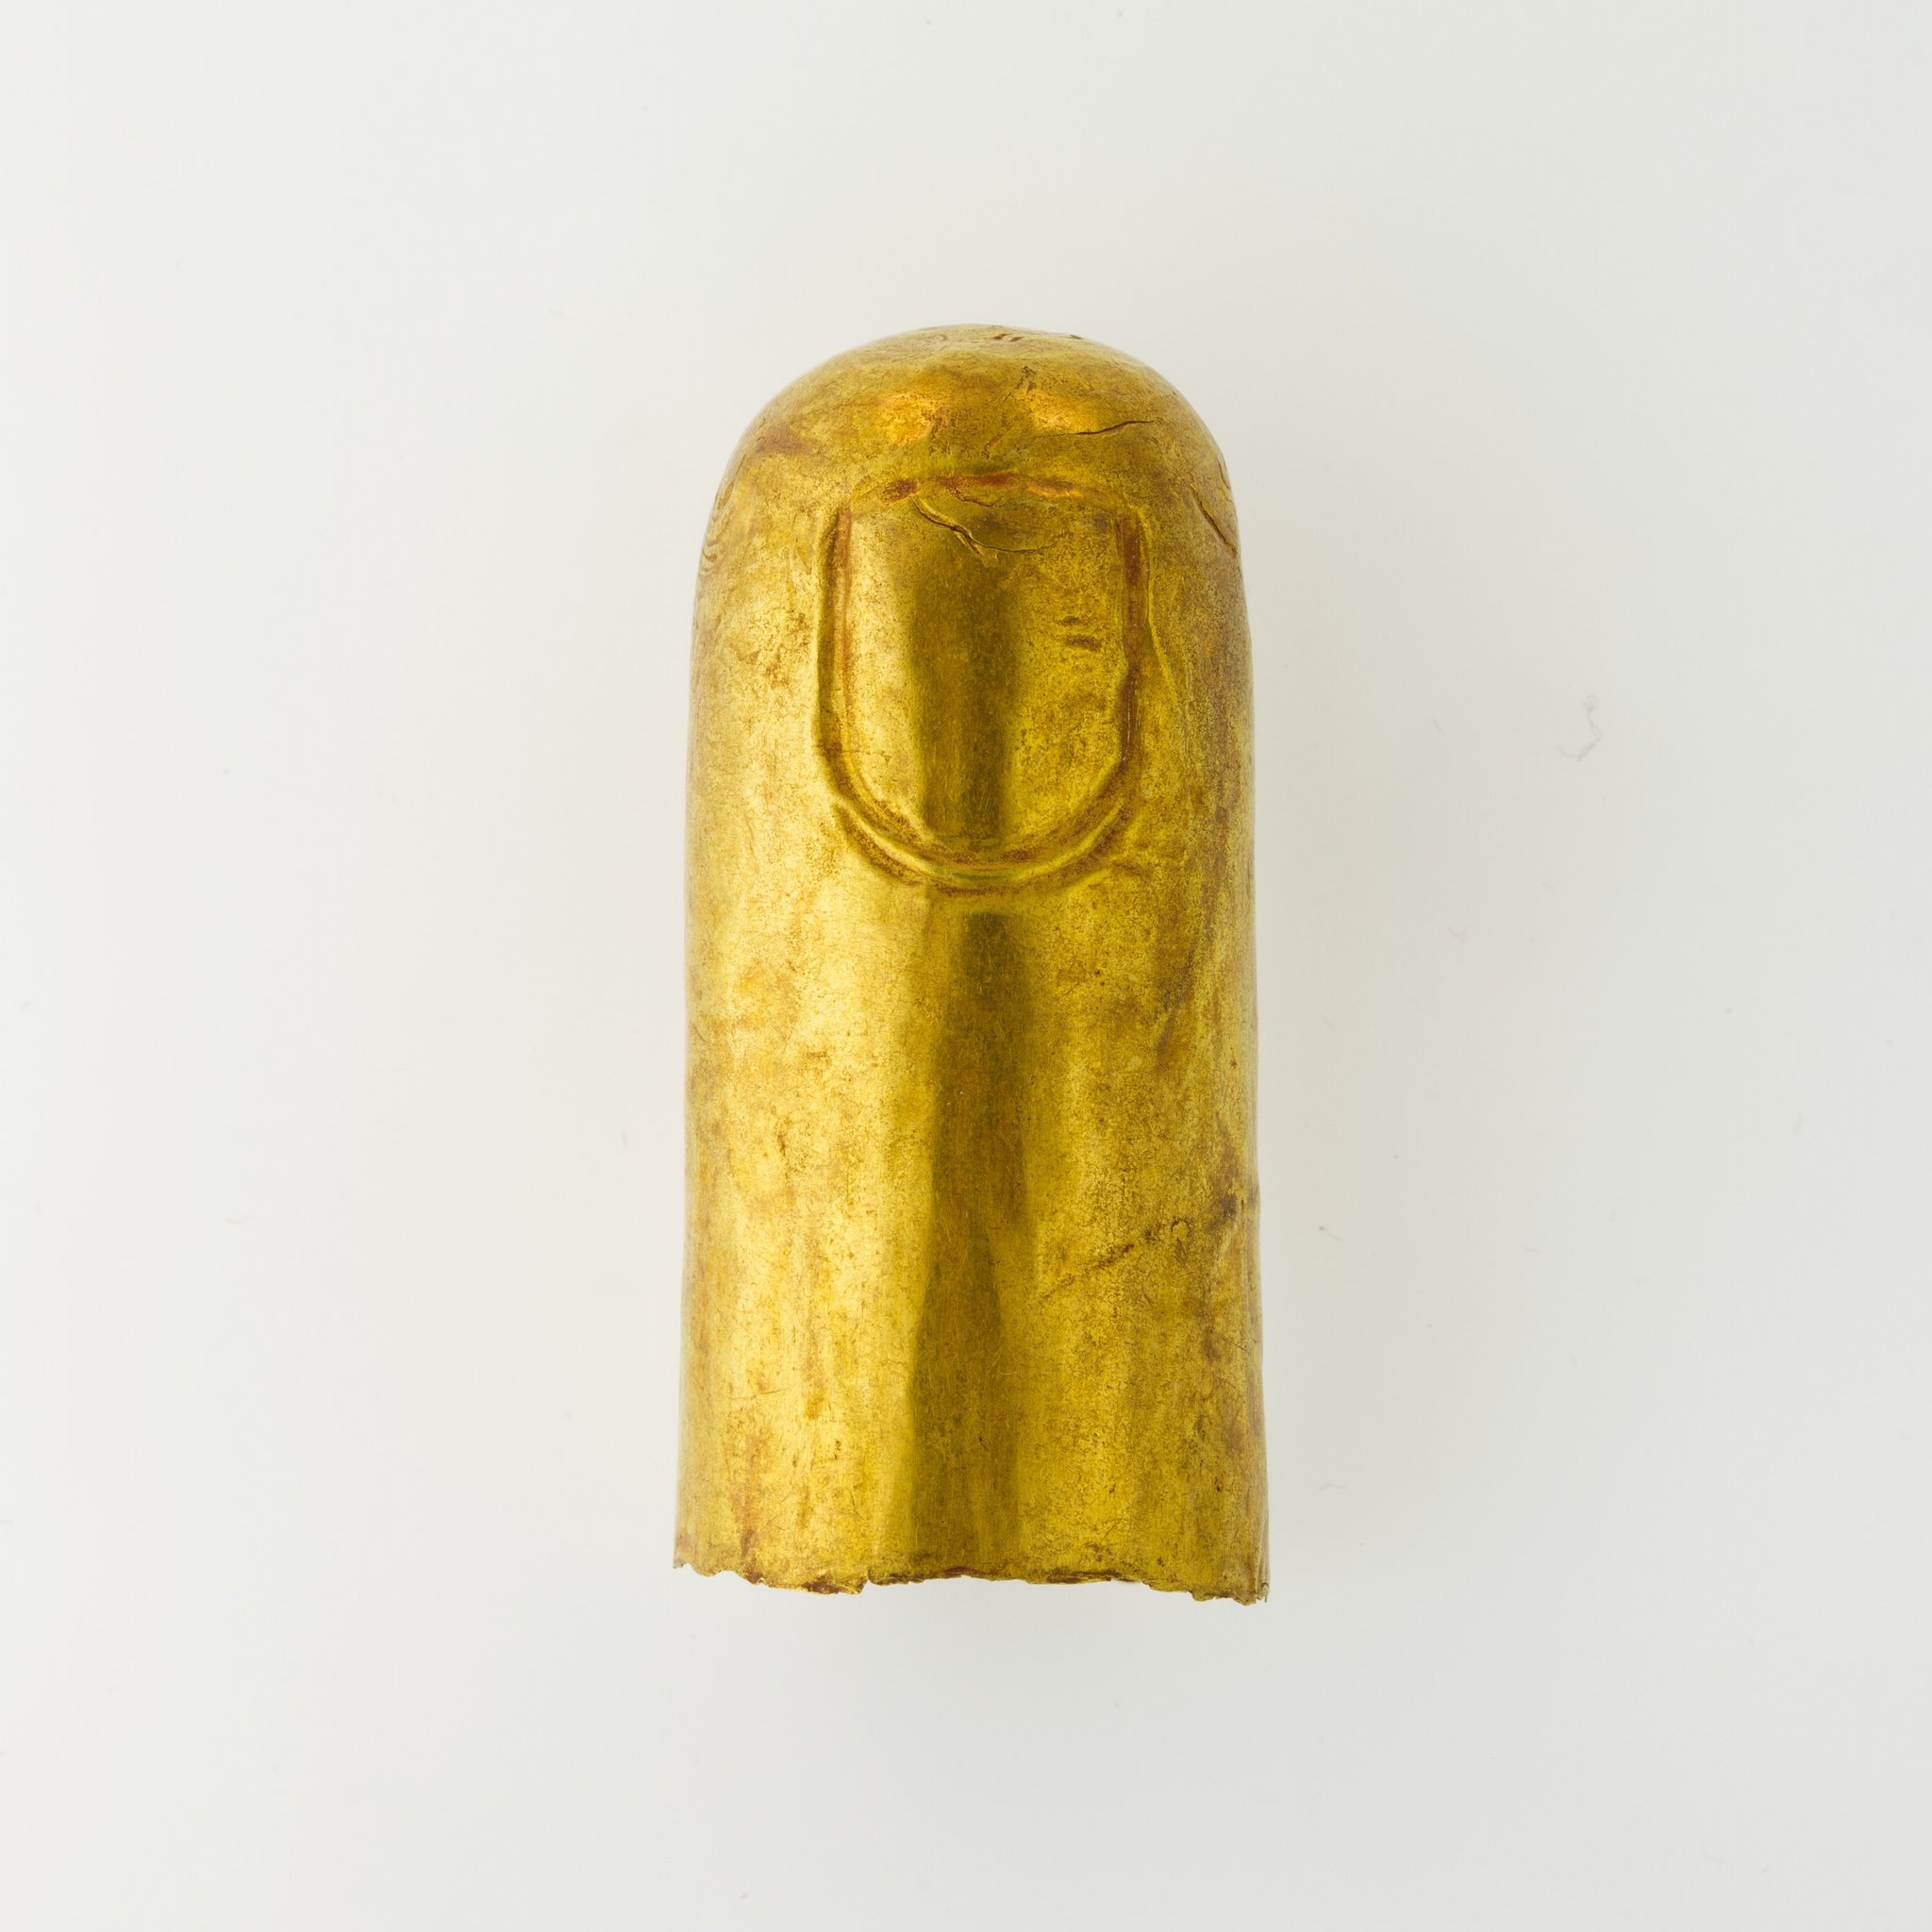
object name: finger stall, group 1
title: Finger stall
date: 1479-1425 BCE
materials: gold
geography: egypt